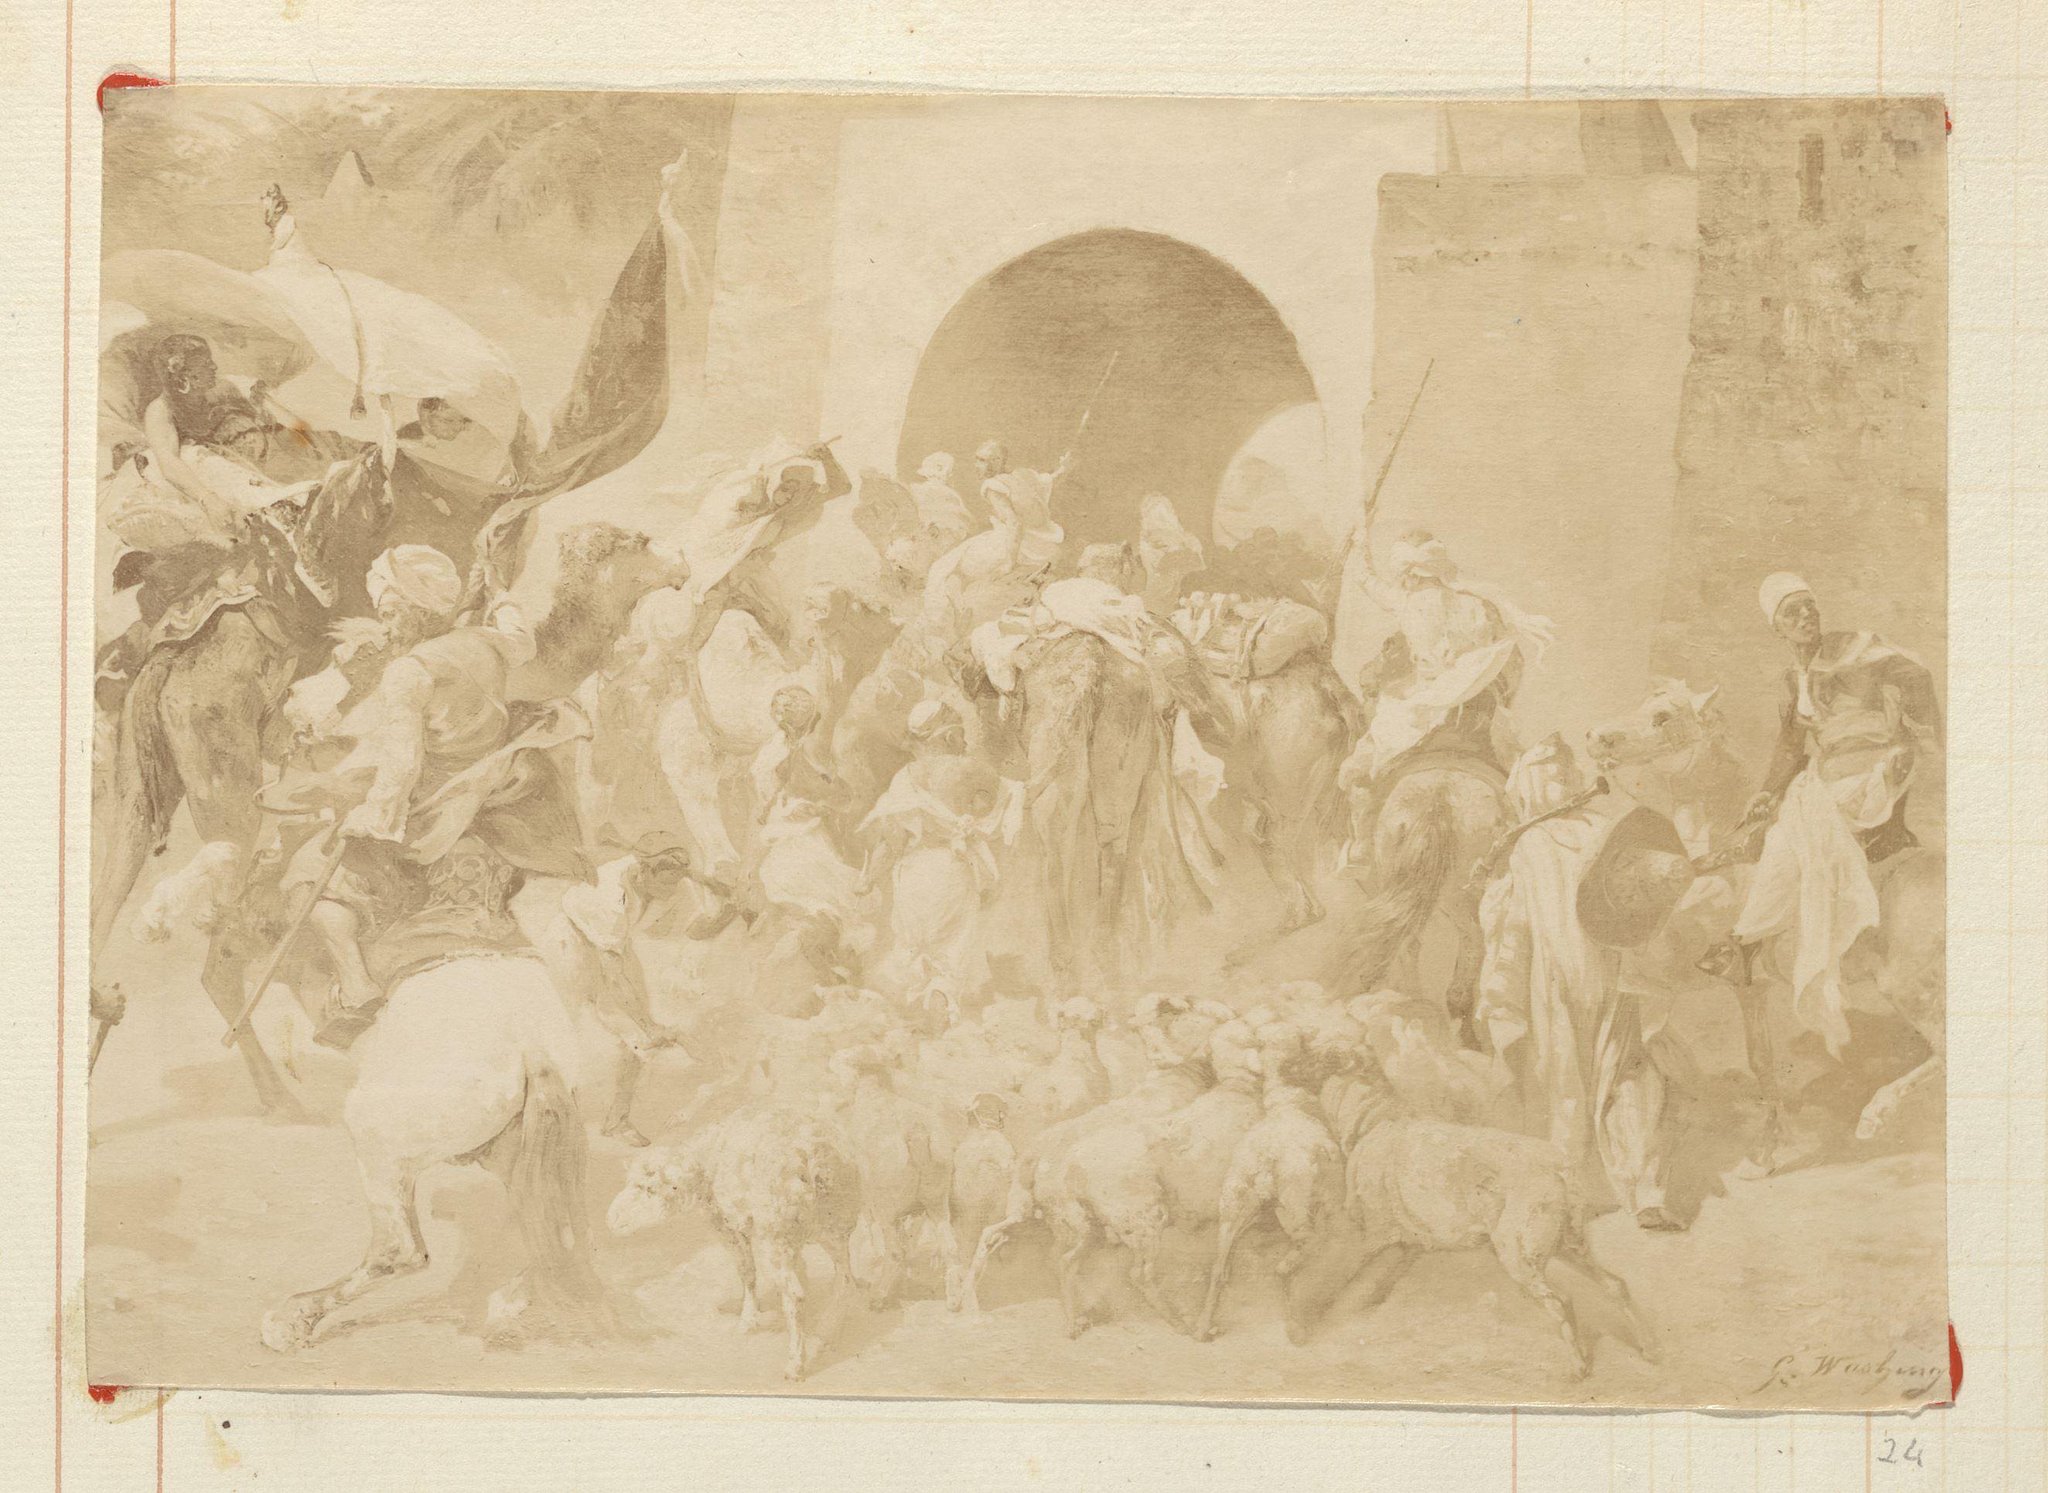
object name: reproduction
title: Fotoreproductie van (vermoedelijk) een schilderij van Georges Washington, voorstellend een oriëntaals tafereel bij een stadspoort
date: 1880-1900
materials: lacquer, paper, photographic support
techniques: albumen print